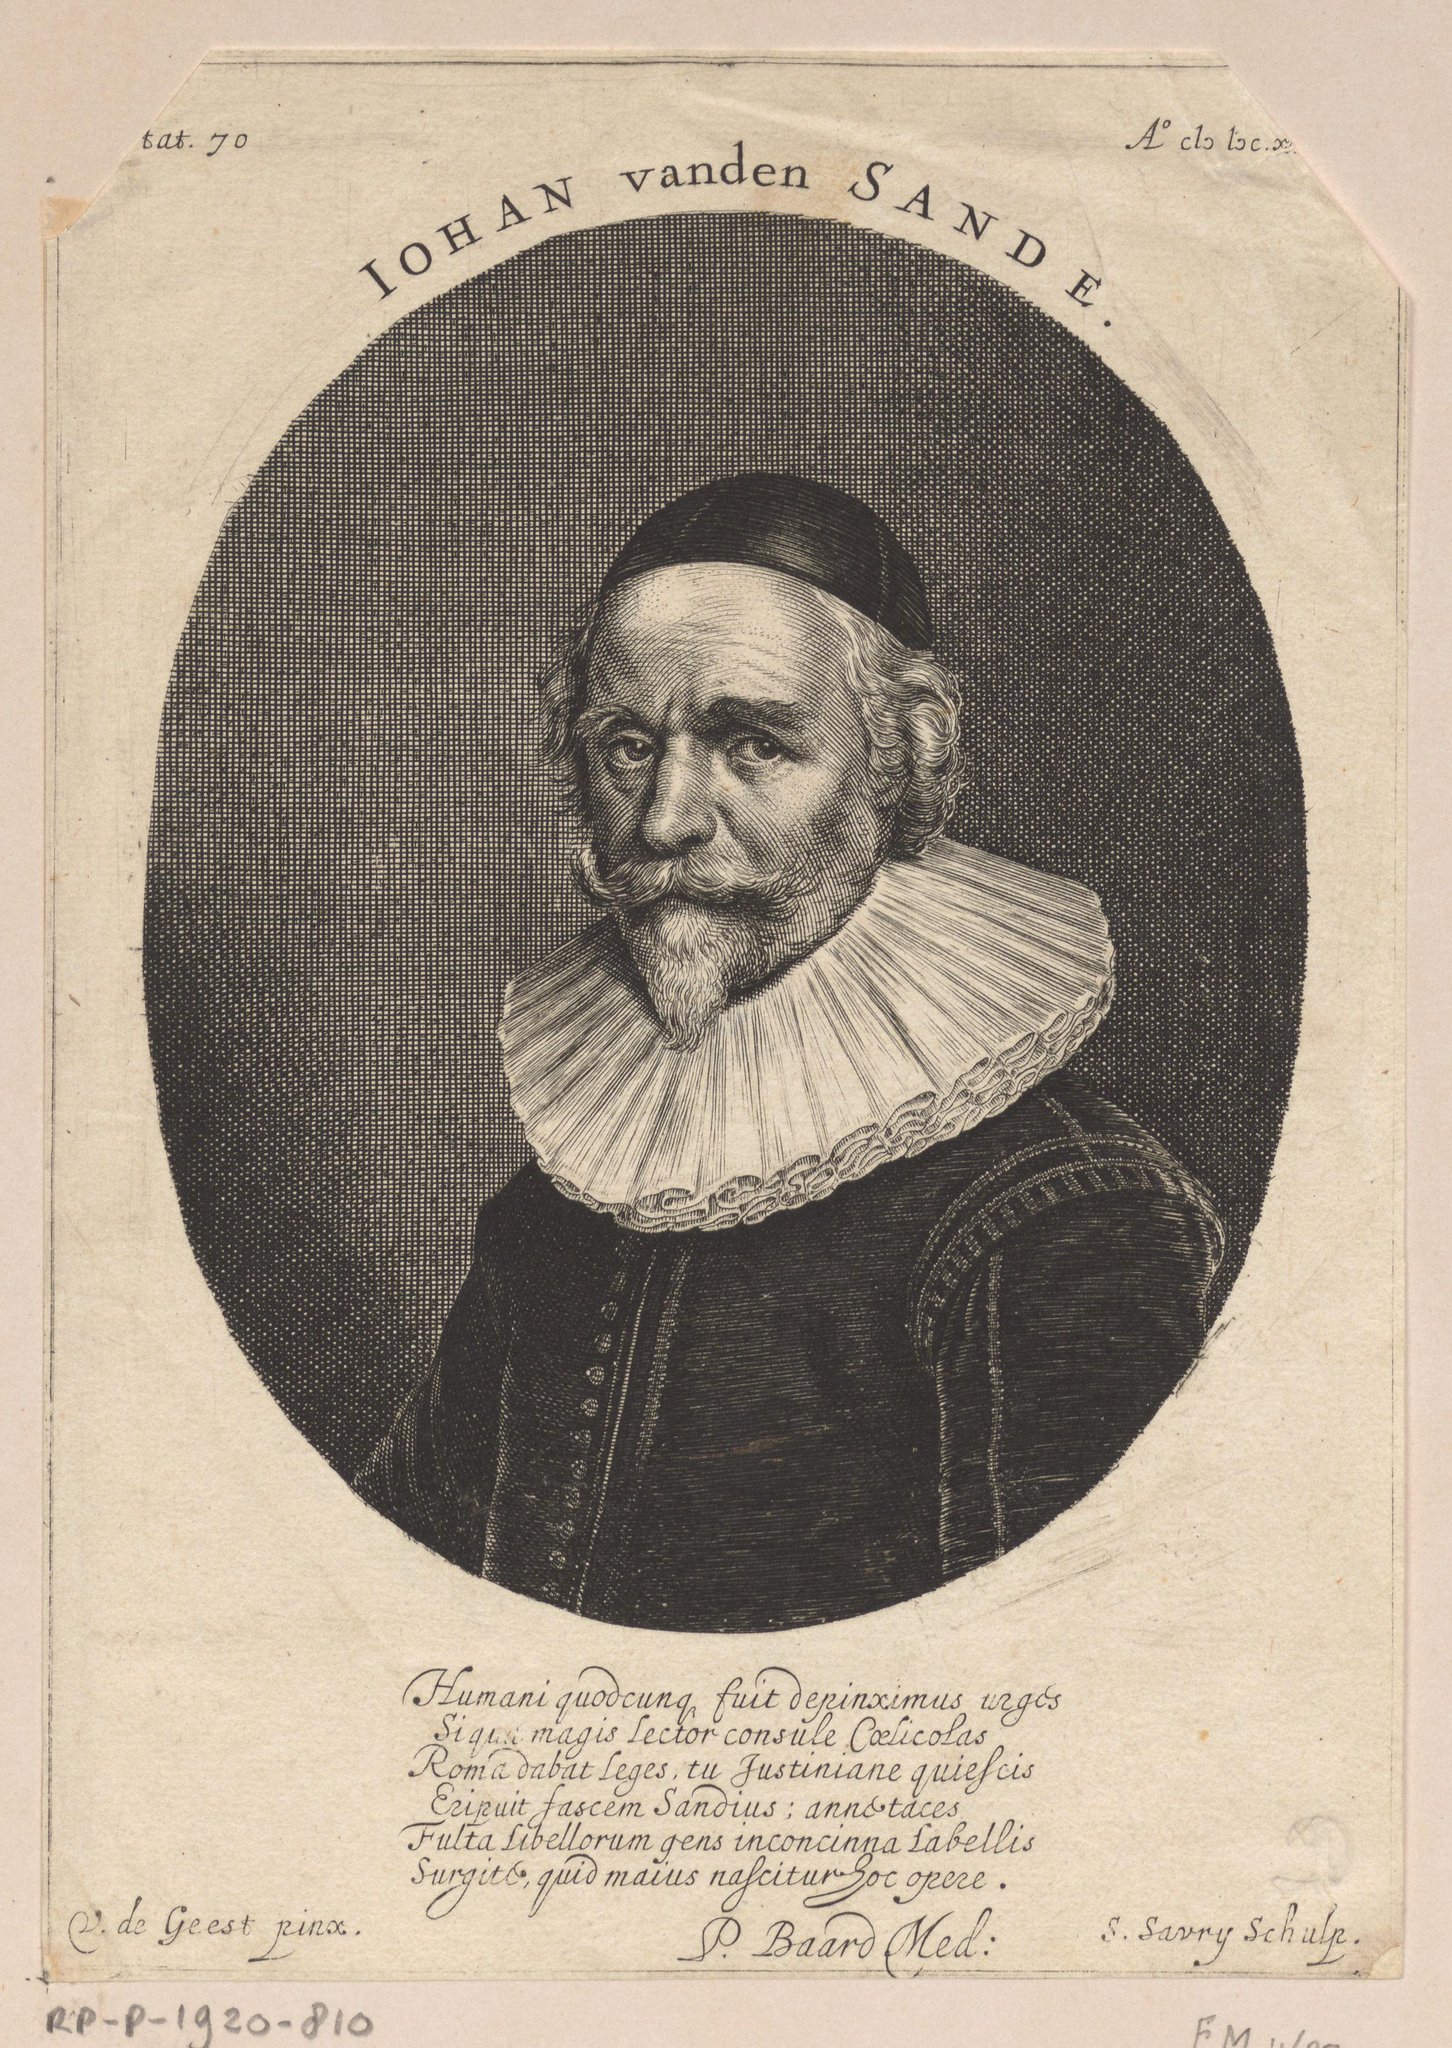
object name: print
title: Portret van Johan van den Sande op 70-jarige leeftijd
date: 1610-1665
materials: paper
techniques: engraving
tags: johan van den sande, historical persons, portrait of a writer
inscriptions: collector's mark: Lugt 2228, inscription: ‘D’